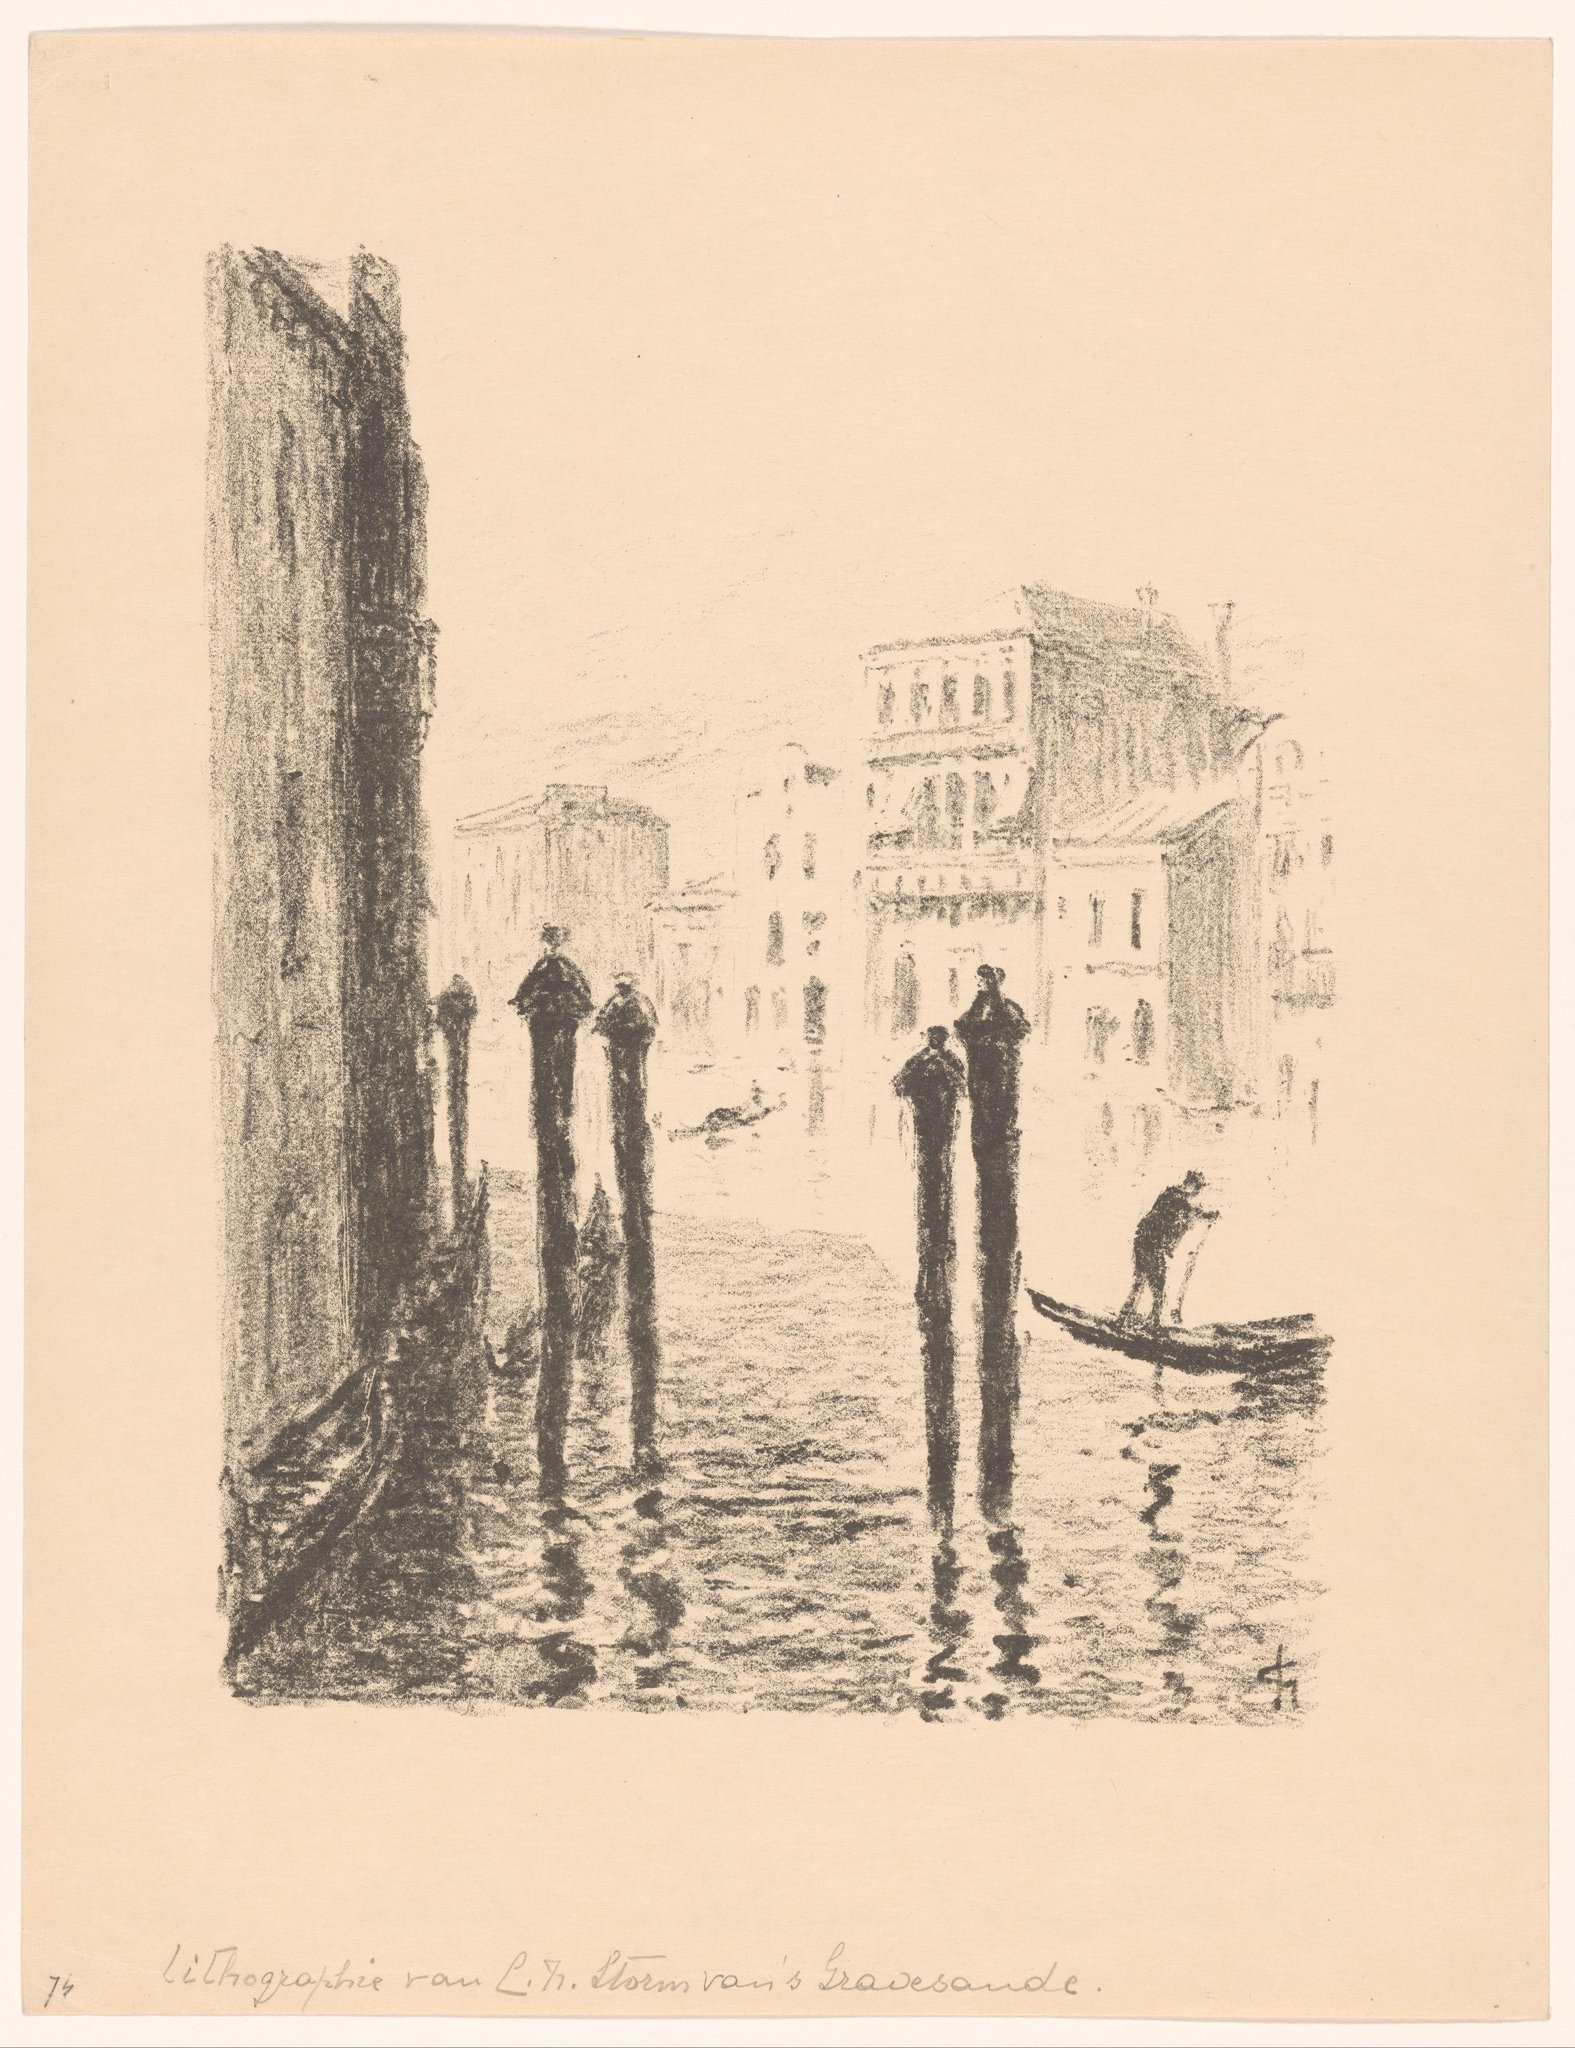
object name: print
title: Kanaal met twee gondels in Venetië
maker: carel nicolaas storm van s-gravesande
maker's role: draughtsman, print maker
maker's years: 1841-1924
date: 1851-1924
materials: paper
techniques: lithograph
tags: gondola, canals, waters (in city) (+ city(-scape) with figures, staffage), venice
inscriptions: collector's mark: Lugt 2228, inscription: ‘lithographie van C.h. Storm van 's Gravesande.’, number: ‘74’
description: Mogelijk vermeld in: Storm van 's-Gravesande, Charles. Catalogue des eaux-fortes et lithographies. New York: s.n., 1903, of in een onbekende latere uitgave van het manuscript. Vermoedelijk vermeld als catalogusnummer 74.